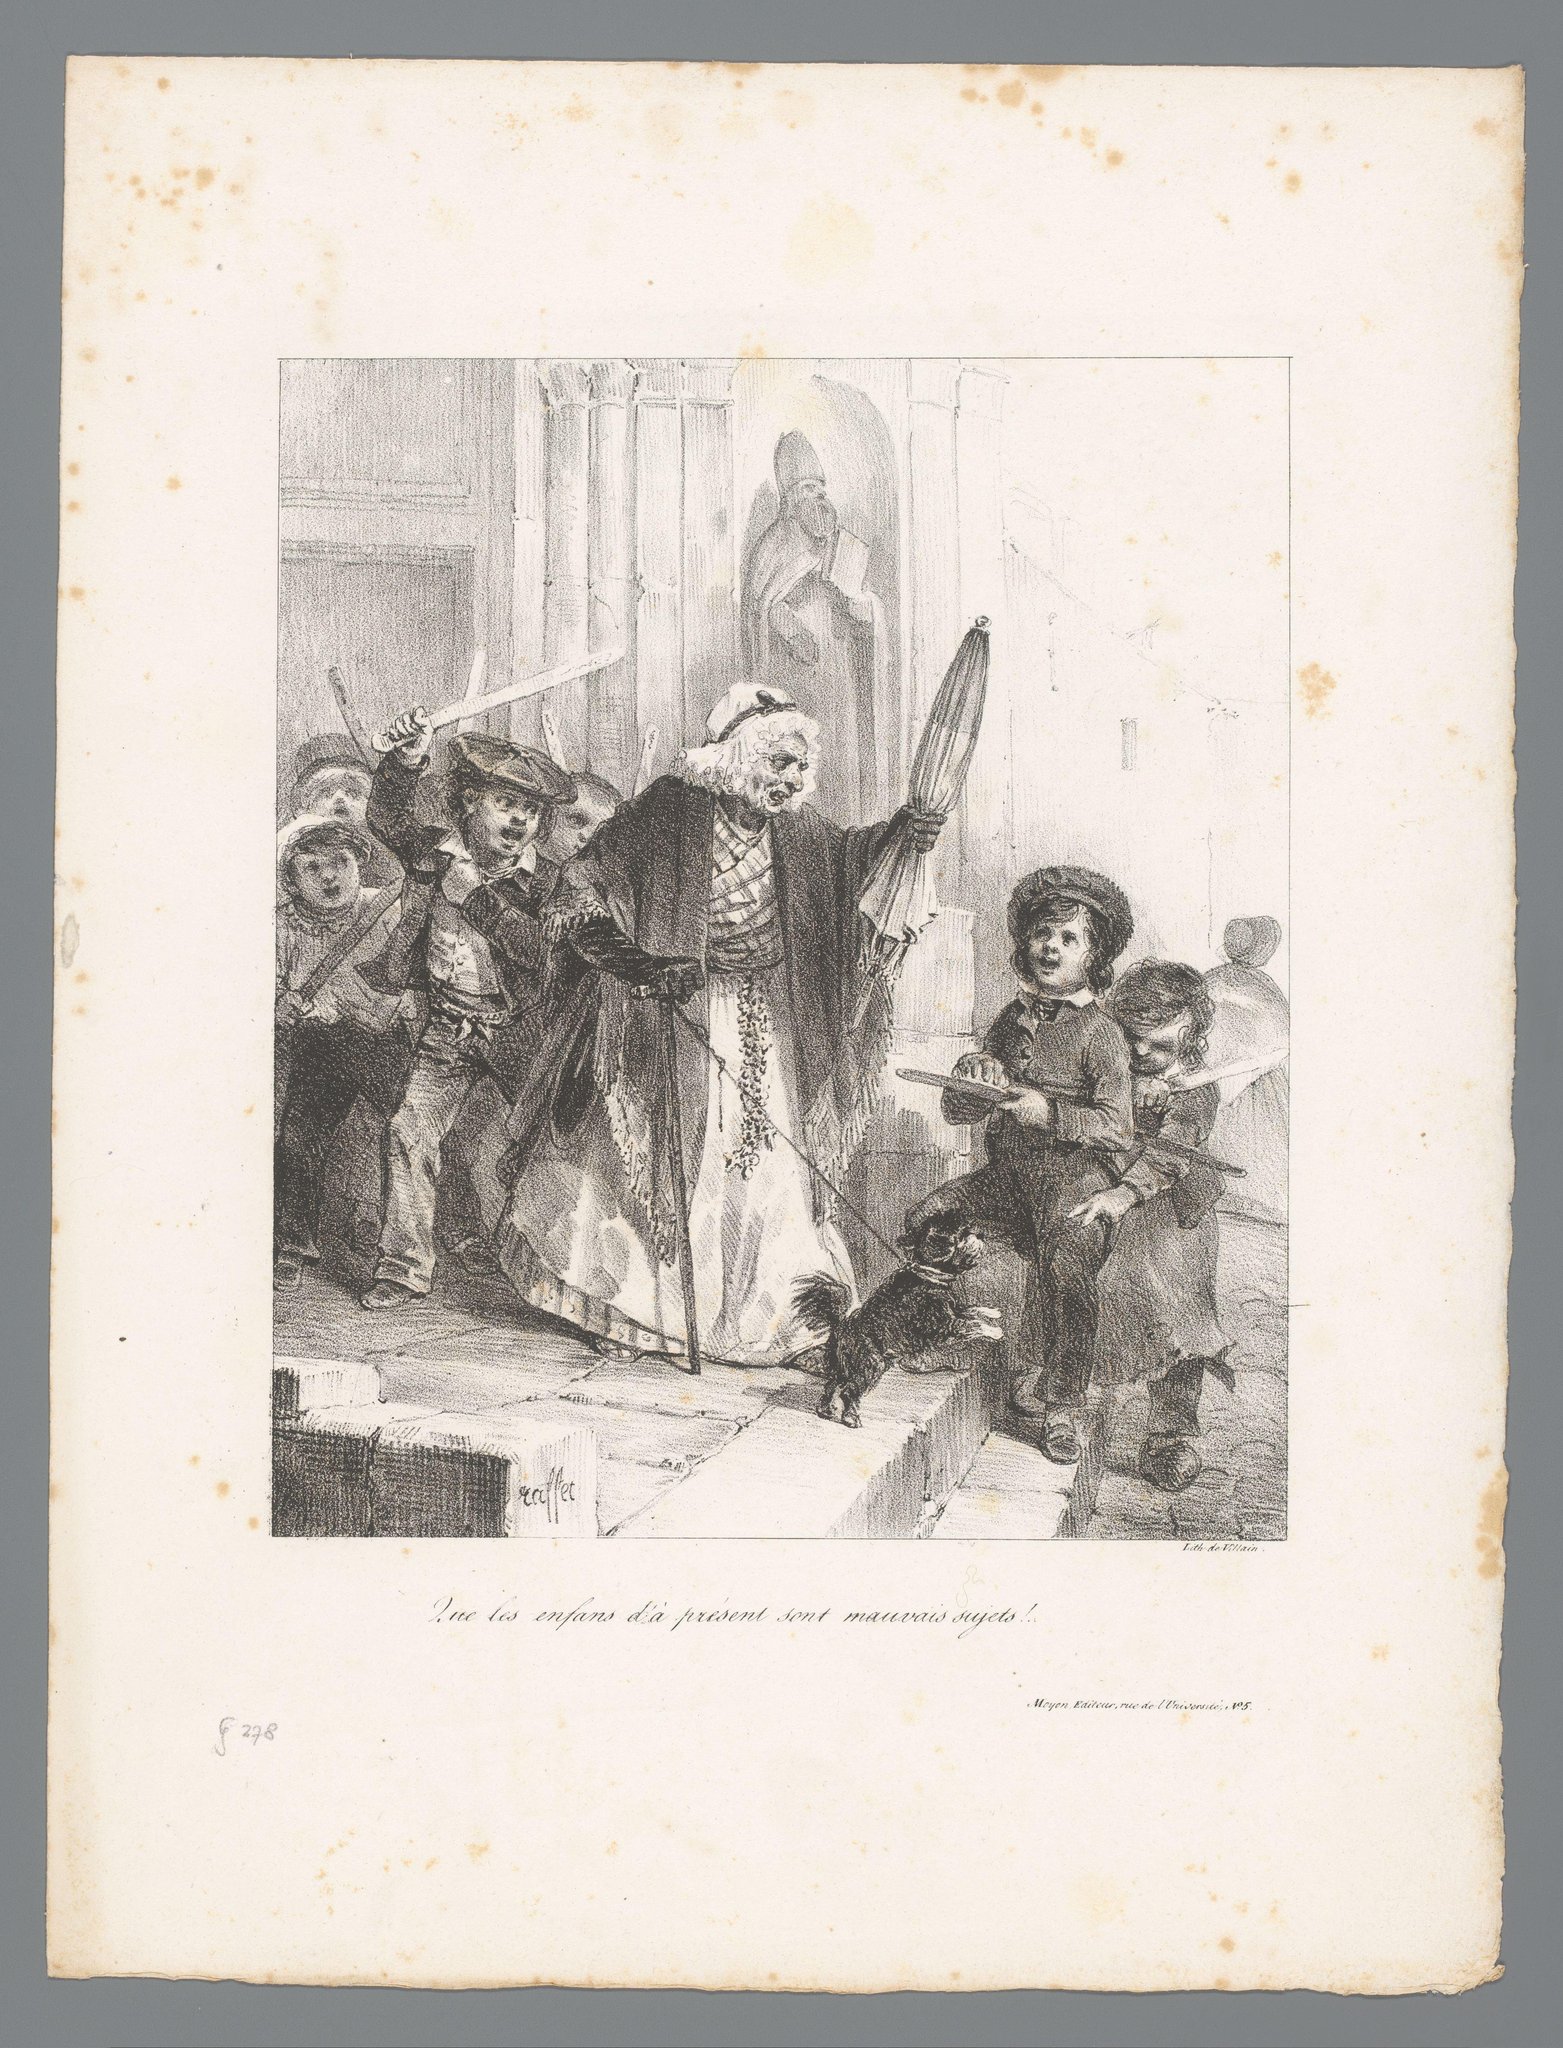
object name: print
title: Que les enfants d'à présent sont mauvais sujets!..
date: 1827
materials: paper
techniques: lithograph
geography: paris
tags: children's games and plays, hacking and thrusting weapons: sword, old woman, umbrella, dog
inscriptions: collector's mark: Lugt 964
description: Serie bestaat uit titelprent en tien prenten. Zevende prent in de serie van elf prenten.